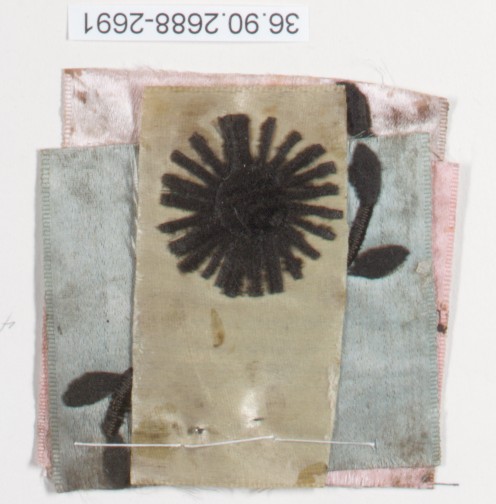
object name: ribbon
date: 1801-1900